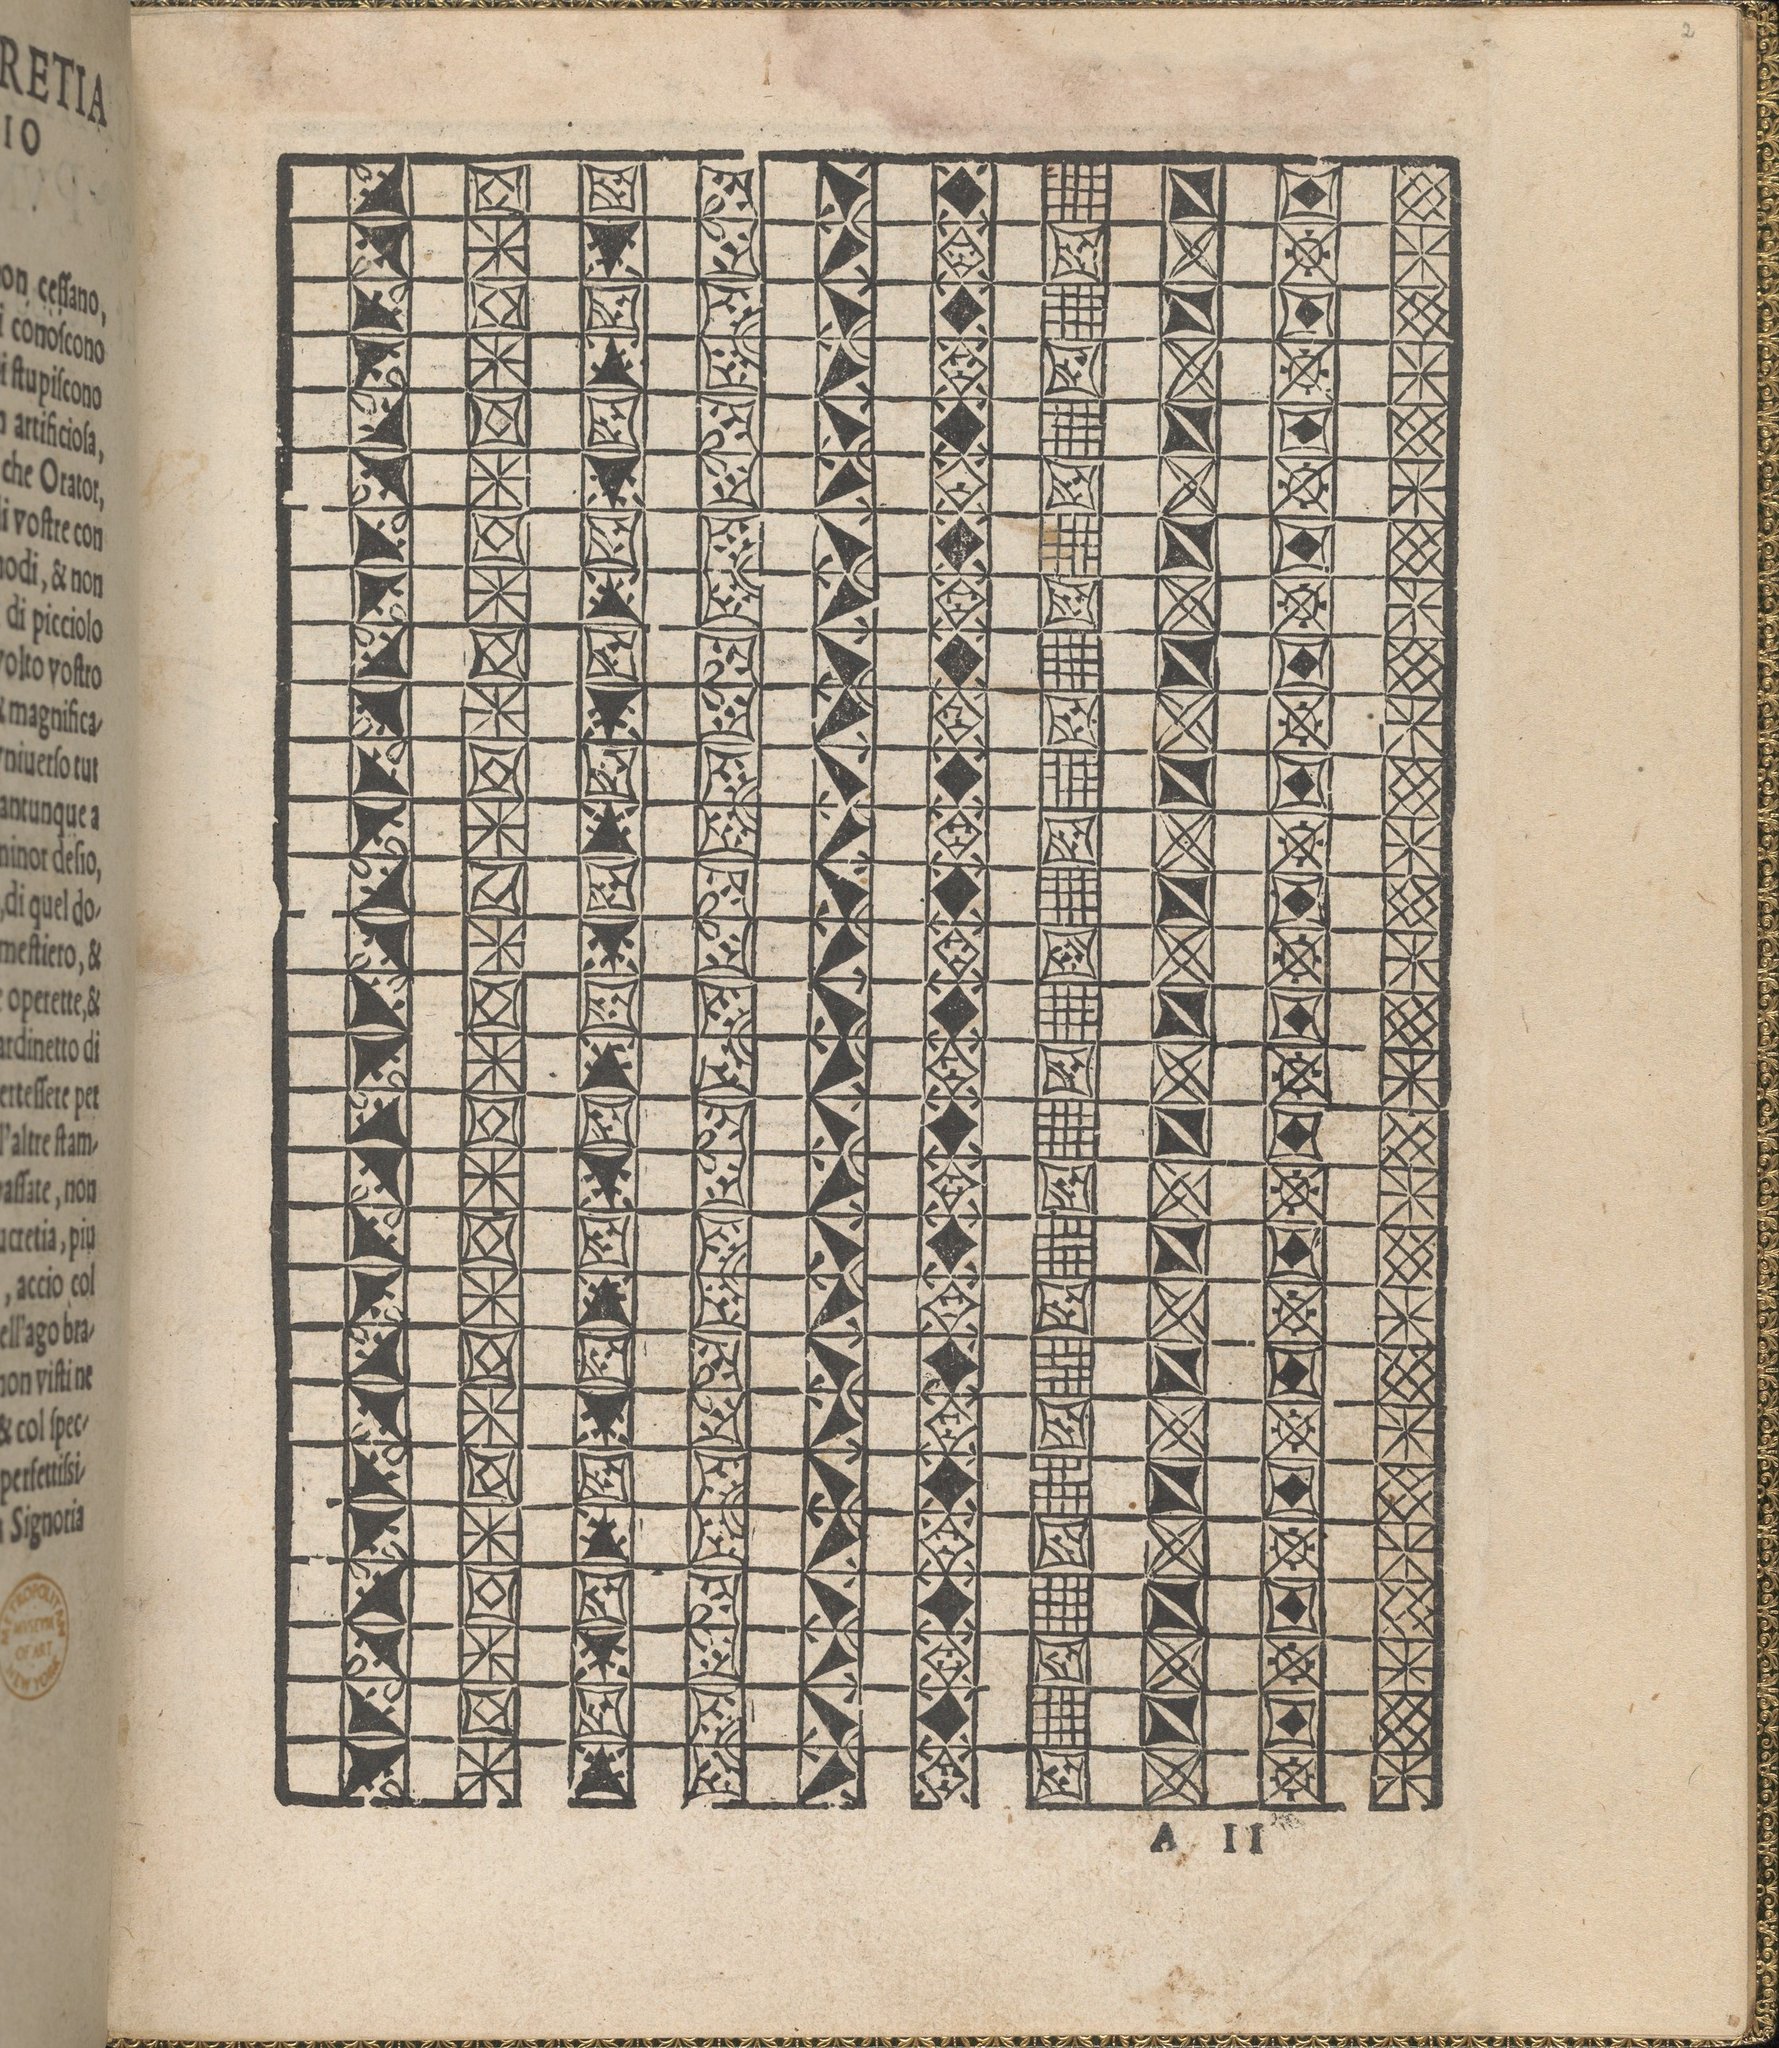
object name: book print ornament architecture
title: Giardineto novo di punti tagliati et gropposi per exercitio & ornamento delle donne (Venice 1554), page 2 (recto)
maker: matteo pagano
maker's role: publisher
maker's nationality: italian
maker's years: 1515-1588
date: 1554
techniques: woodcut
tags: ornament